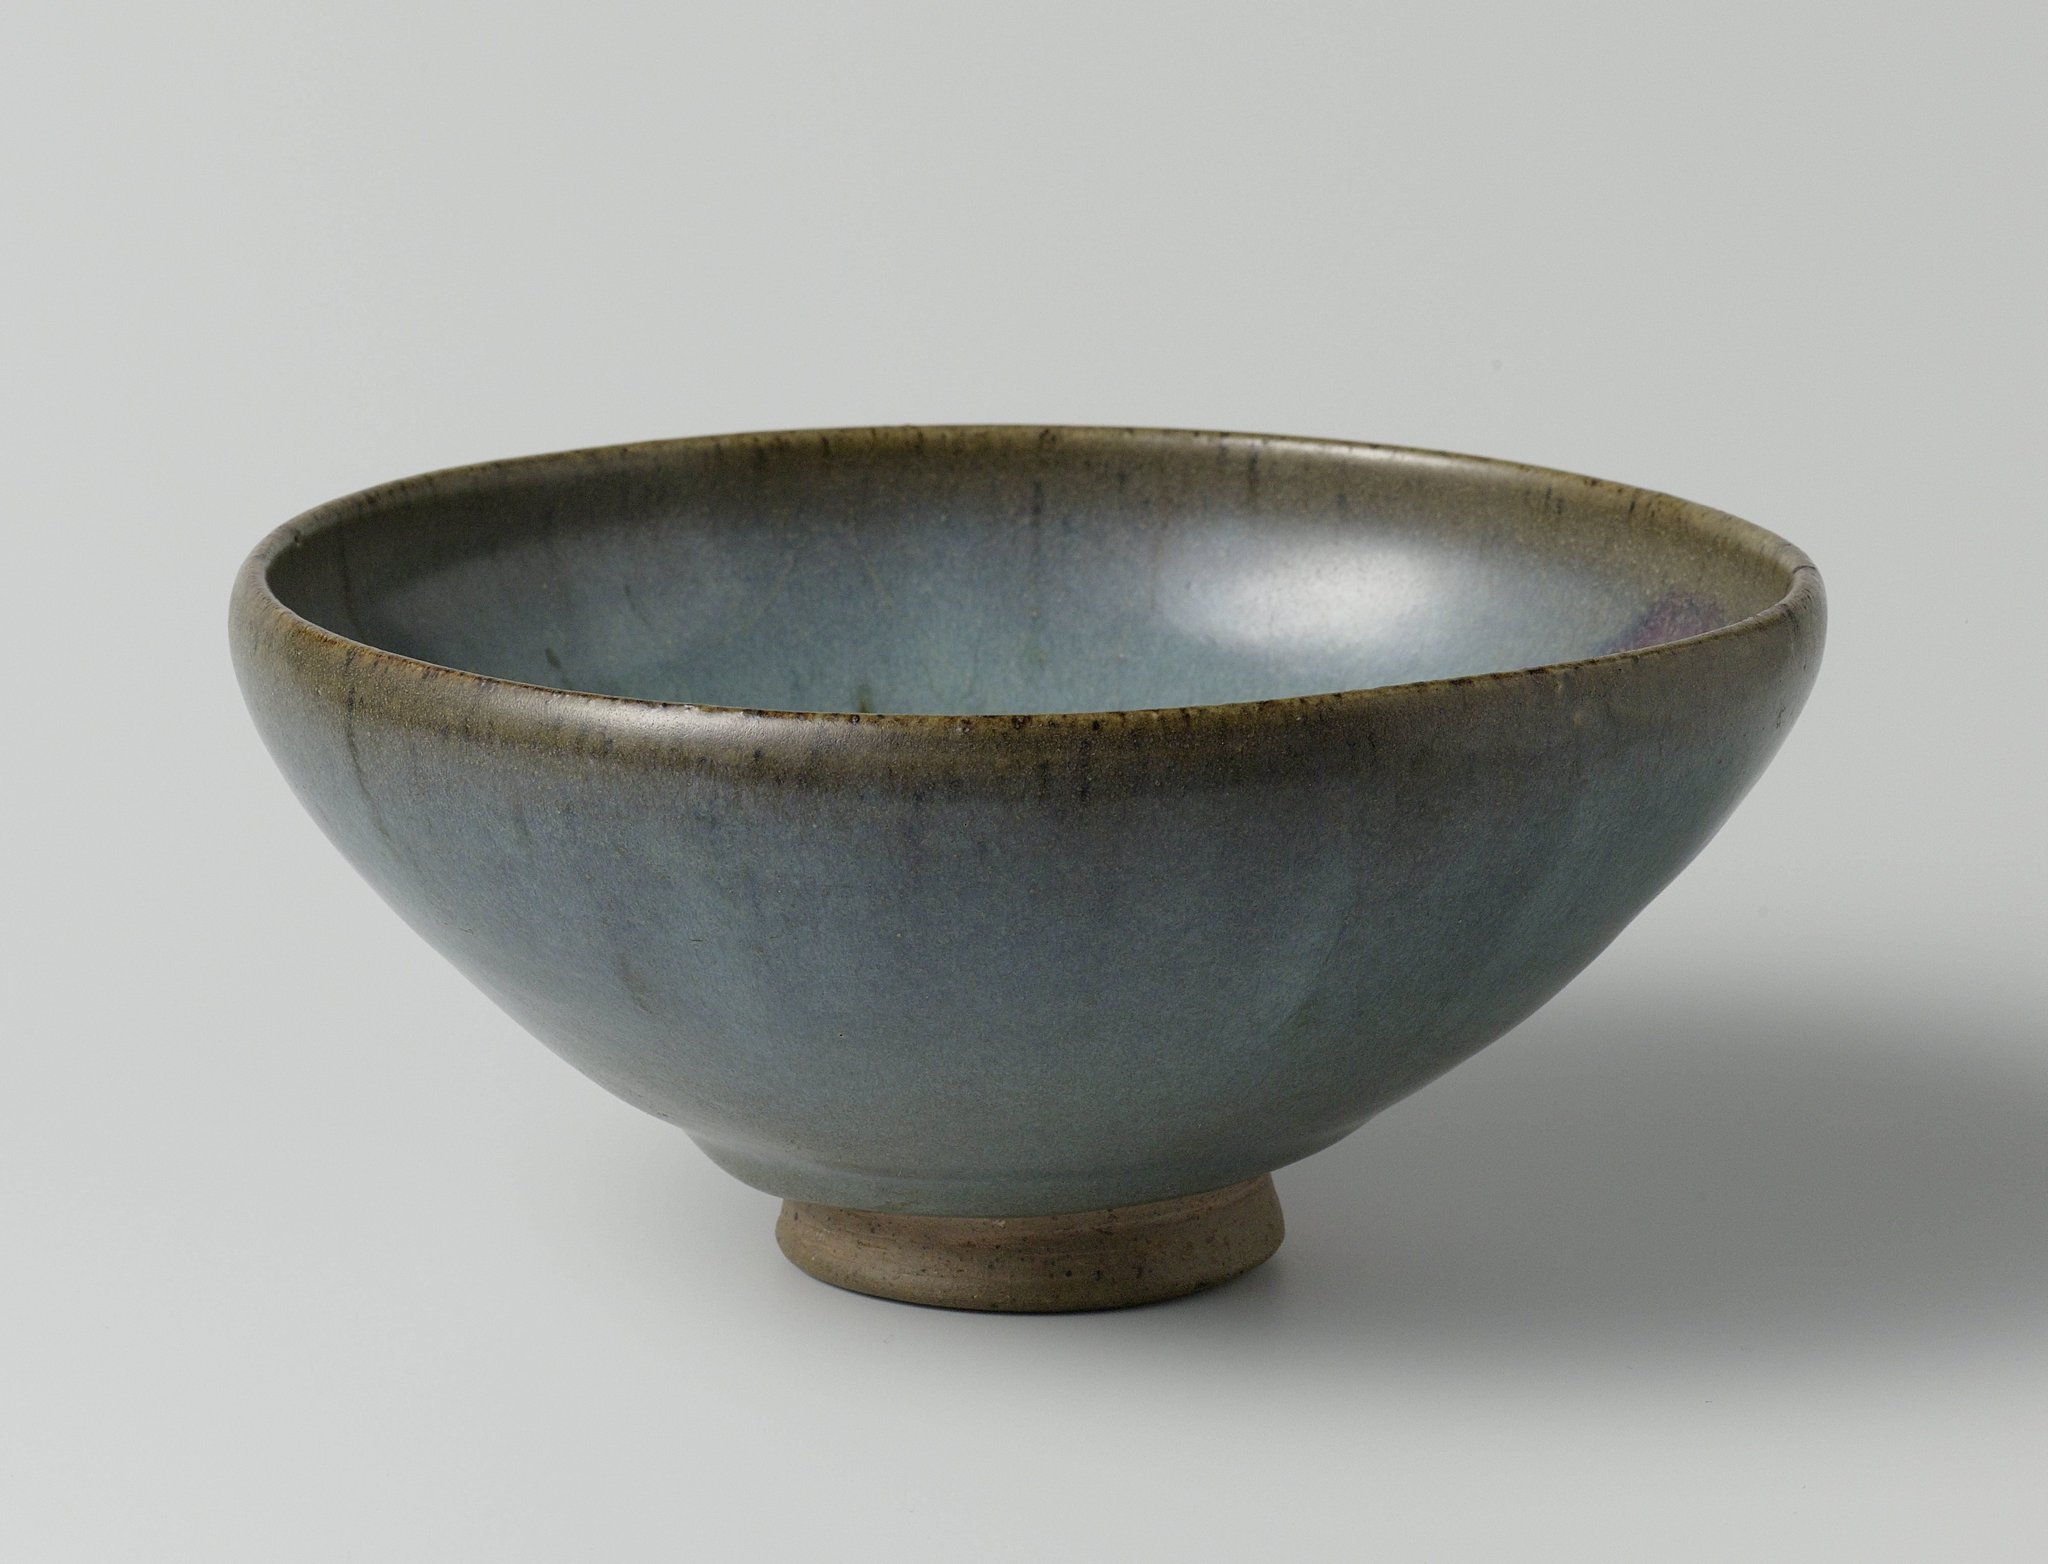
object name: bowl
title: Bowl with a lavender blue glaze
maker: Anonymous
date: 1100-1299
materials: glaze, stoneware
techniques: firing, turning, vitrification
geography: china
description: The glaze of Jun ware from the Yuan Dynasty (1279-1368) is bright blue, thick, and opaque. The sky blue colour of these objects was derived by mixing iron and copper, and monitoring the kiln temperature closely while the objects were being fired. The oxidized copper particles produced purple spatters.